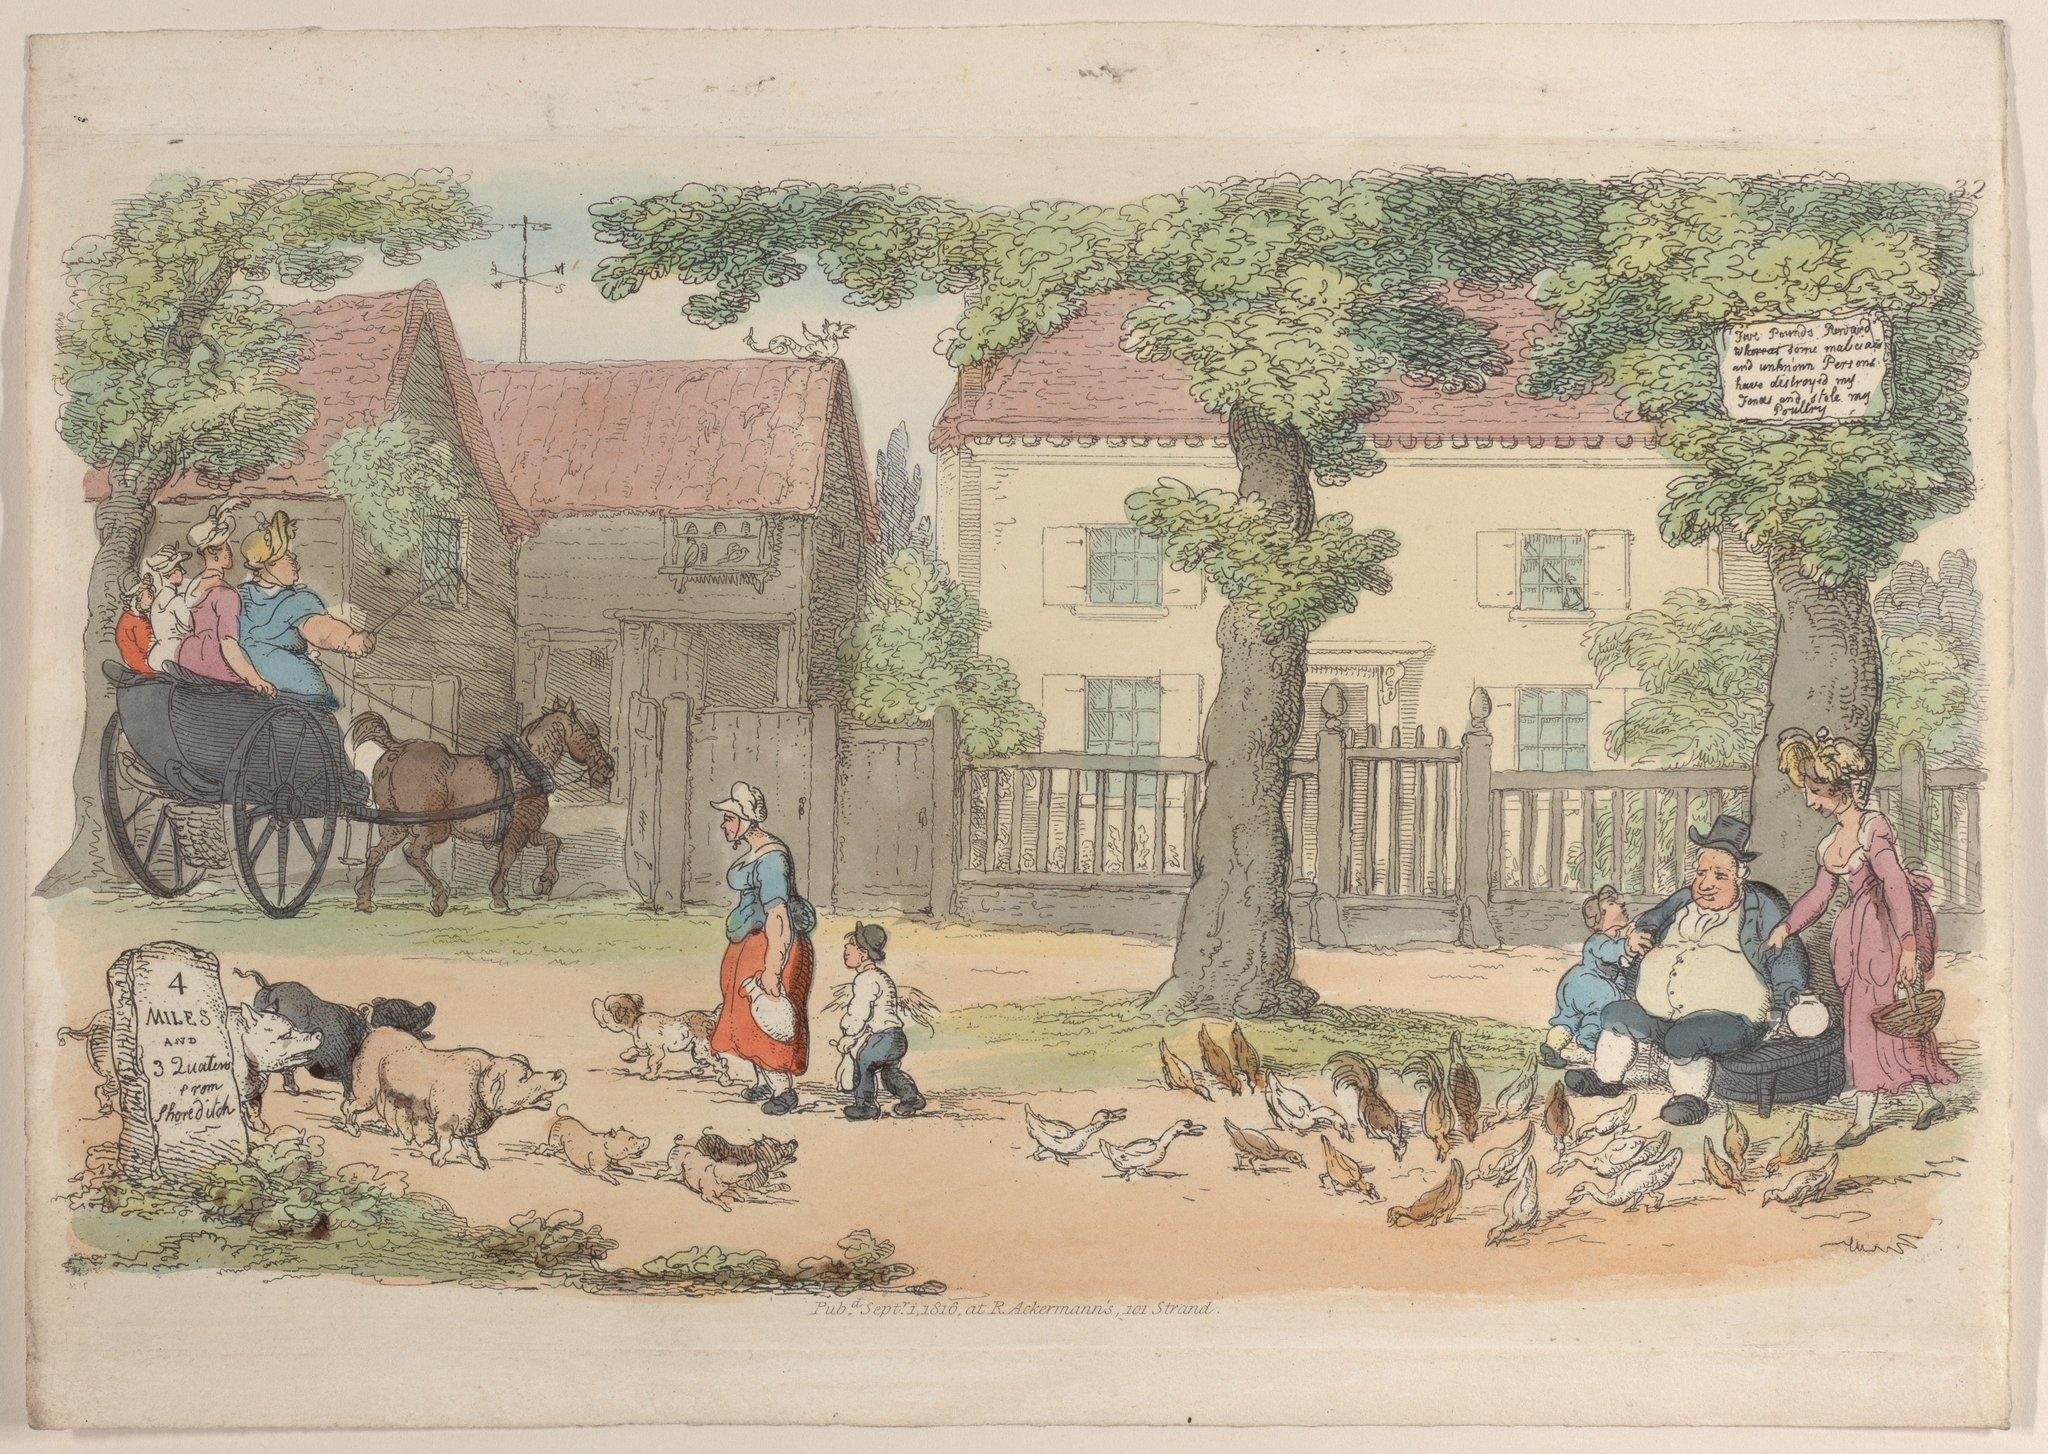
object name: print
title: Plate 32, from "World in Miniature"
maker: thomas rowlandson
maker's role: artist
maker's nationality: british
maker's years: 1757-1827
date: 1816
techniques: etching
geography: london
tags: birds,children,men,women,dogs,horses,carriages